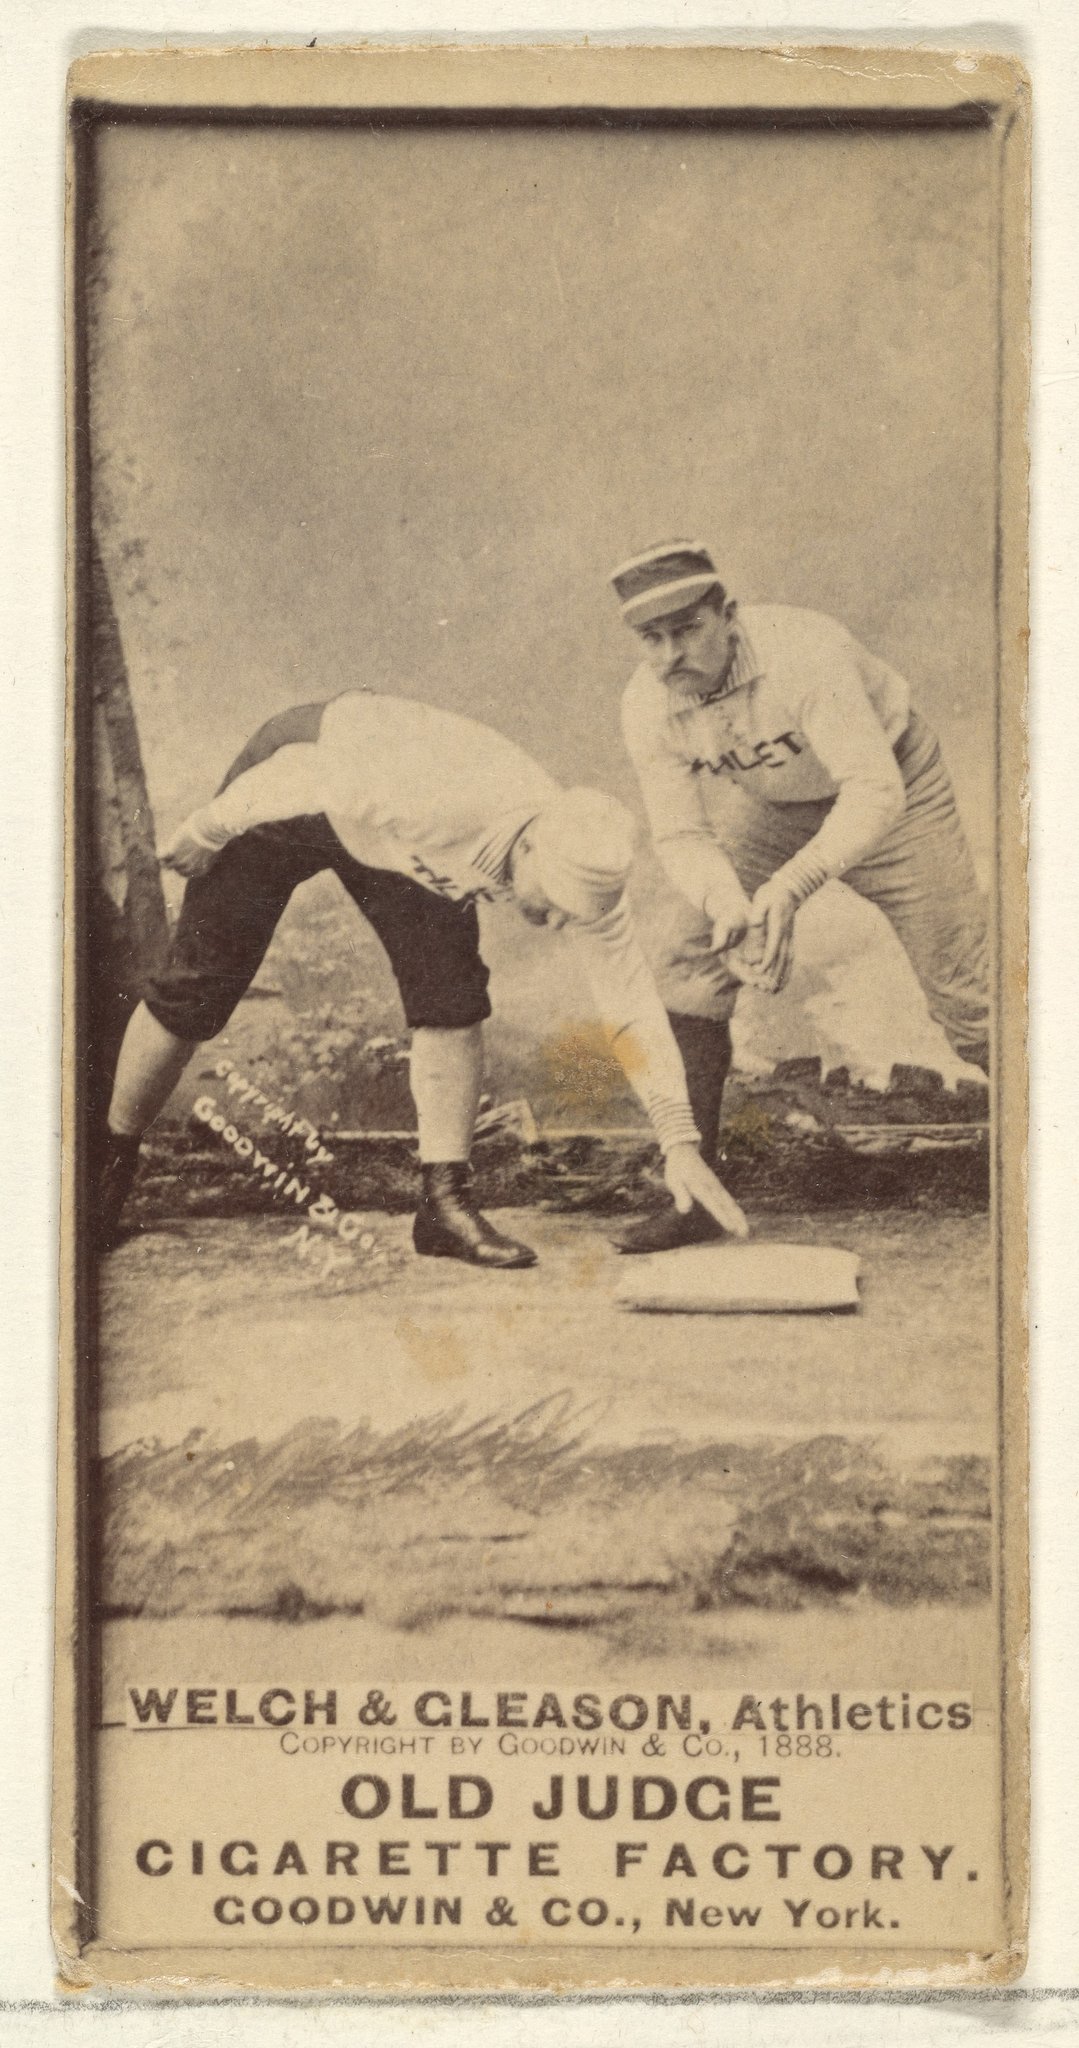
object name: baseball card, photograph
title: Welch and Gleason, Philadelphia Athletics, from the Old Judge series (N172) for Old Judge Cigarettes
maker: goodwin & company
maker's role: publisher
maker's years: 1850-1950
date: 1888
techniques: albumen silver print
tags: men,portraits,baseball,athletes